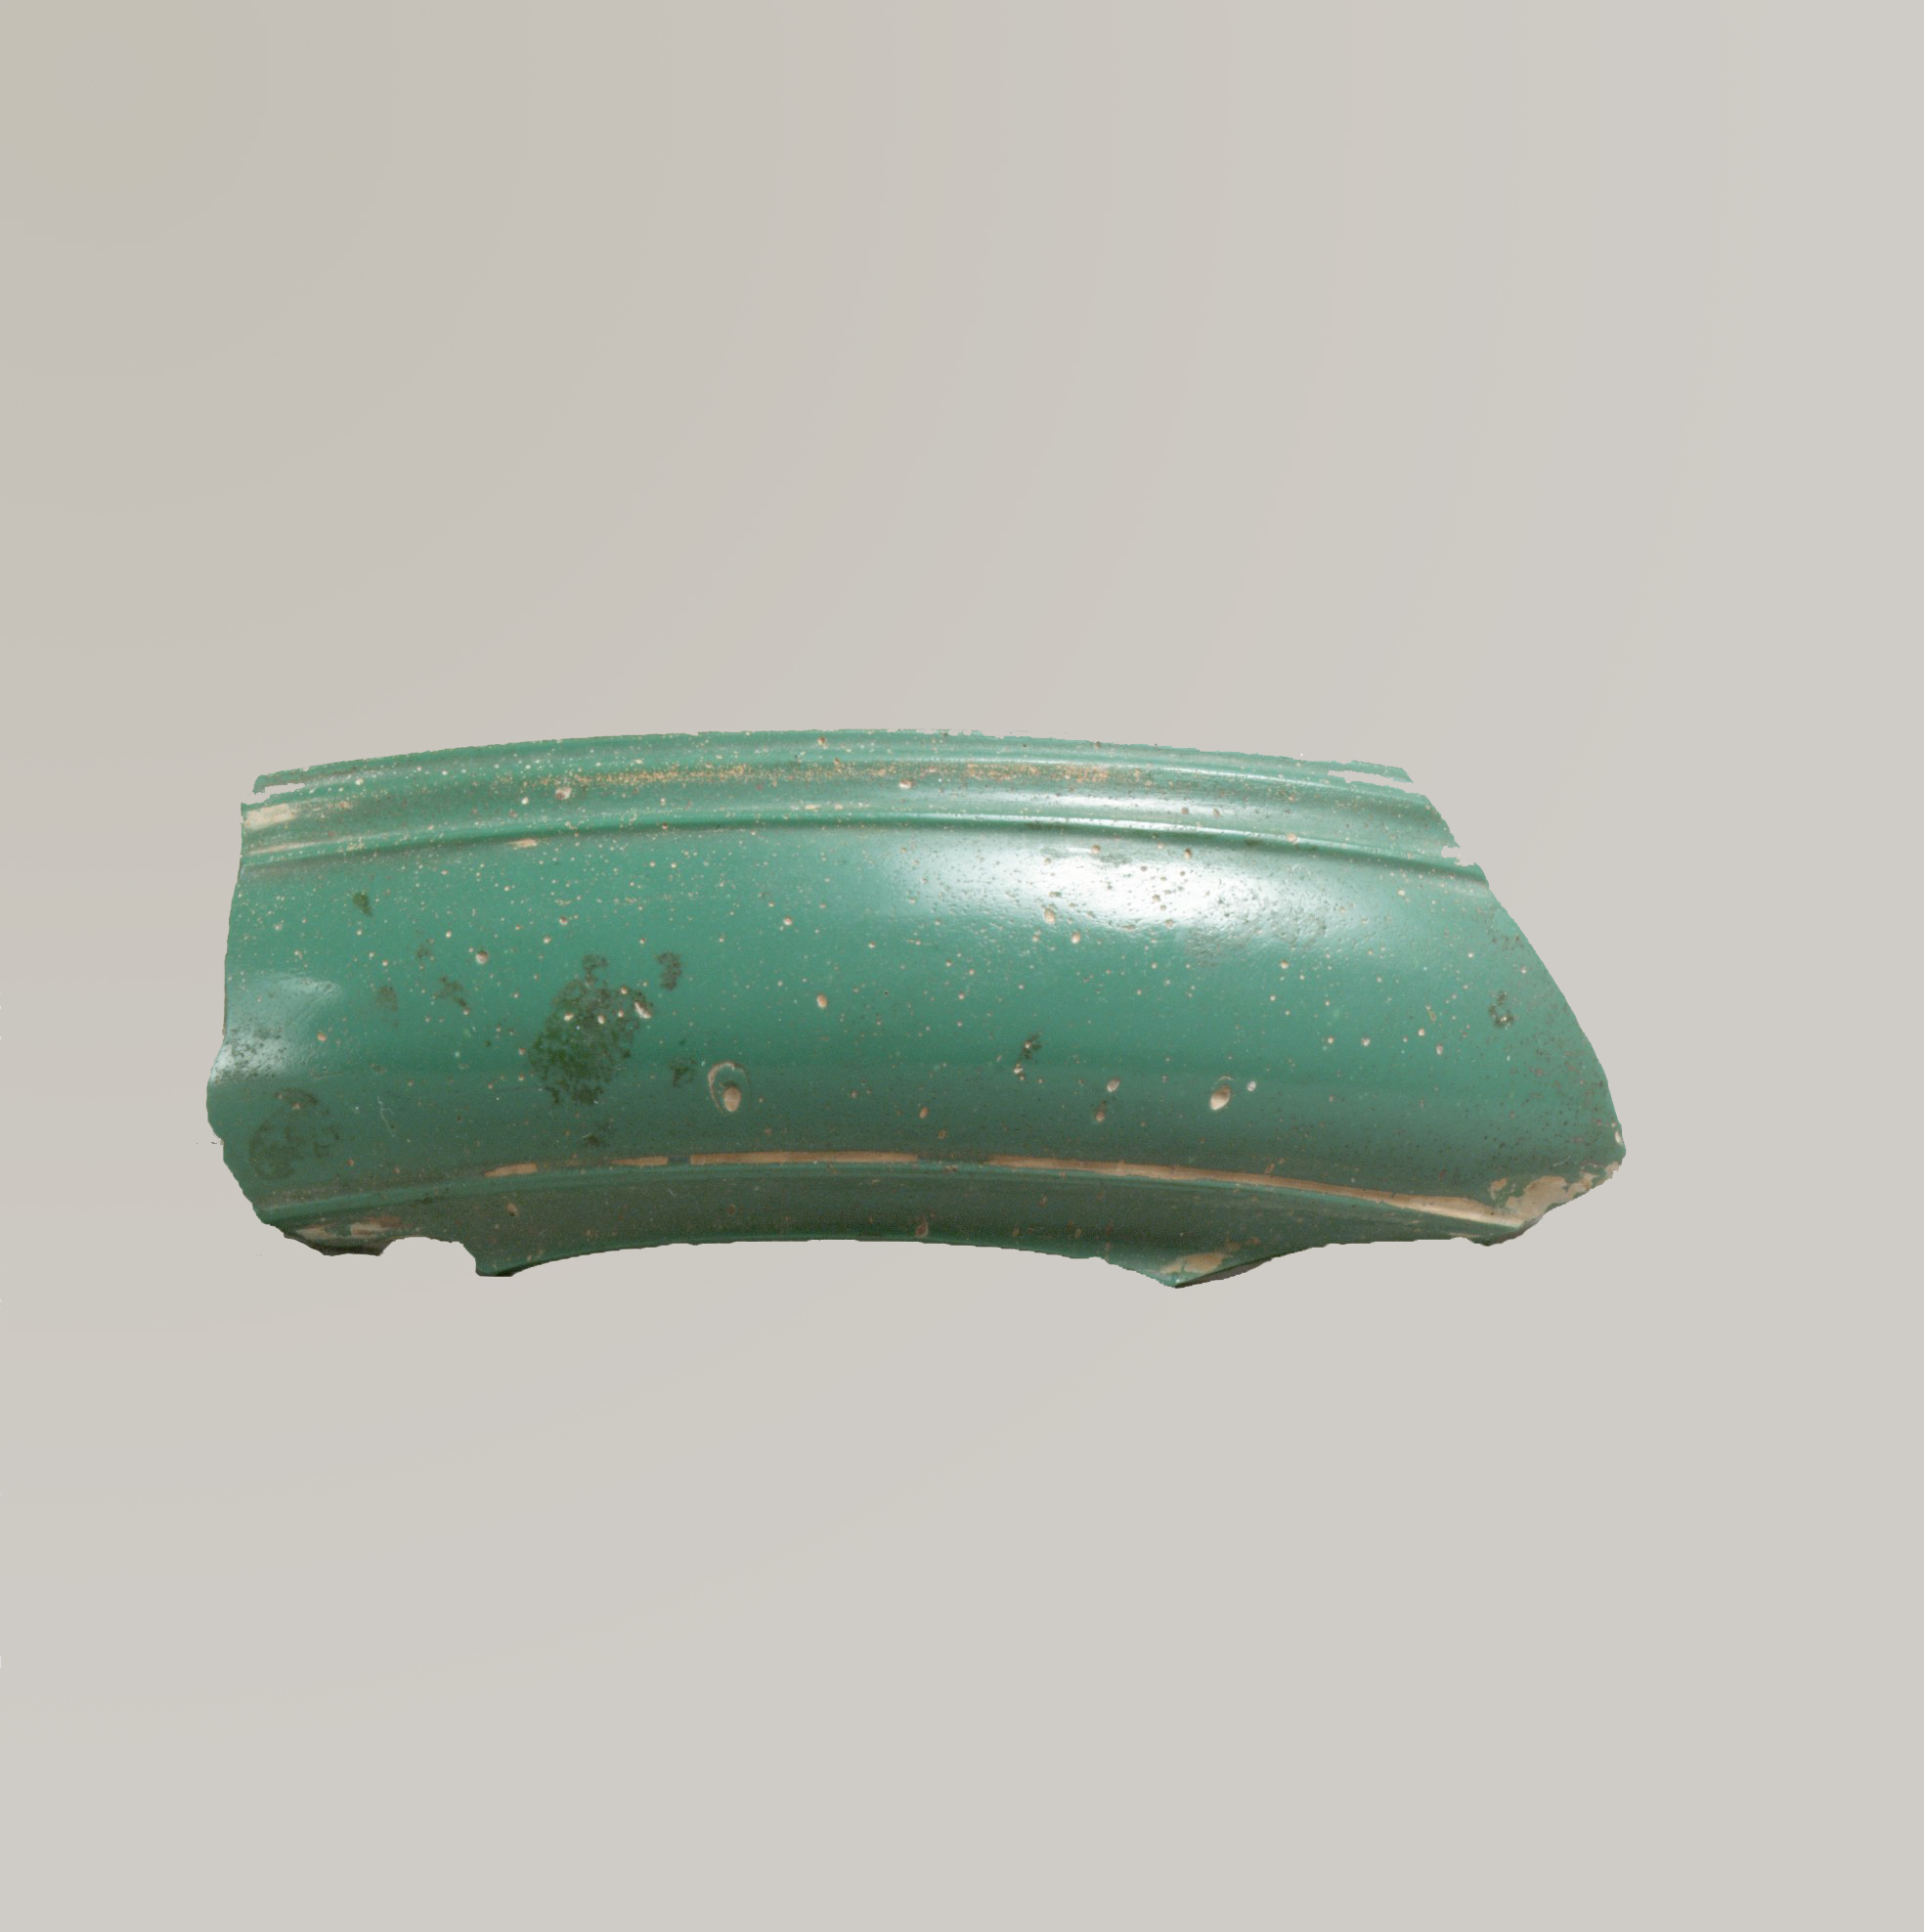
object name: fragment, monochrome dish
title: Glass monochrome dish fragment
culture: roman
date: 1-50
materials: glass